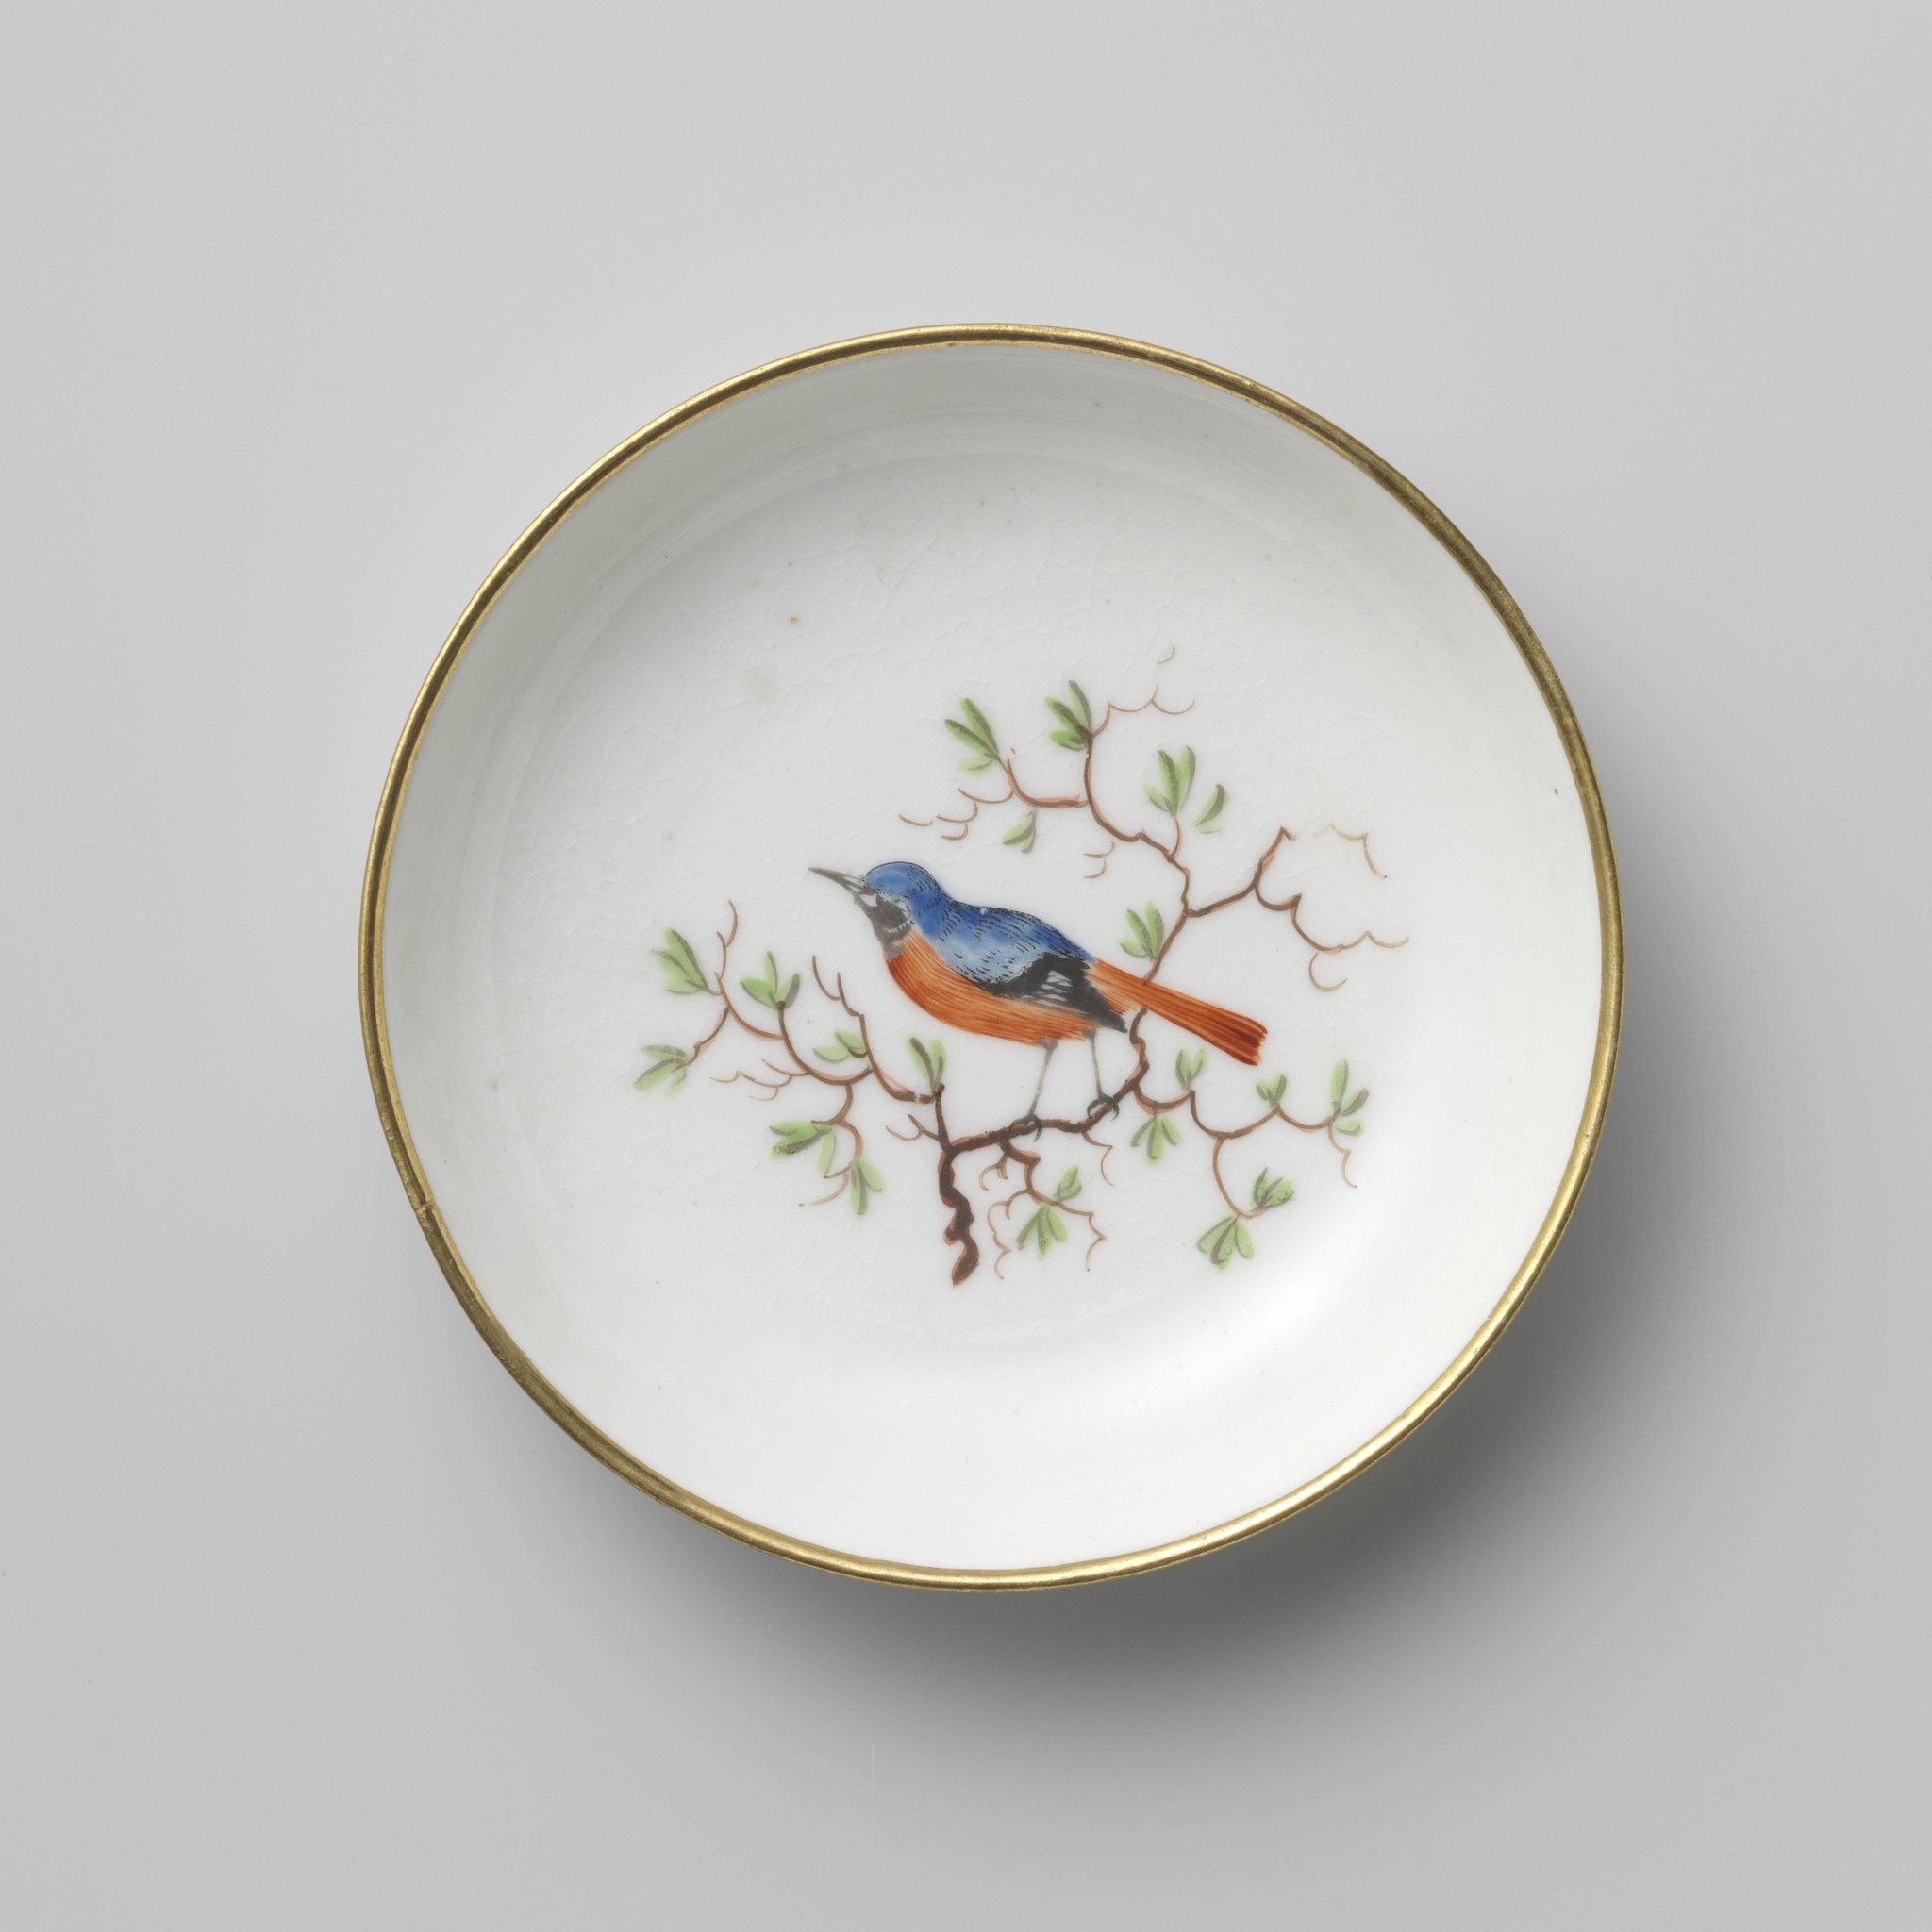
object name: platter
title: Schotel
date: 1809-1814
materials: porcelain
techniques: painted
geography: nieuwer-amstel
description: Schotel veelkleurig beschilderd met een vogel op een tak. Gemerkt: Amstel in zwart en ingegrift A en K.